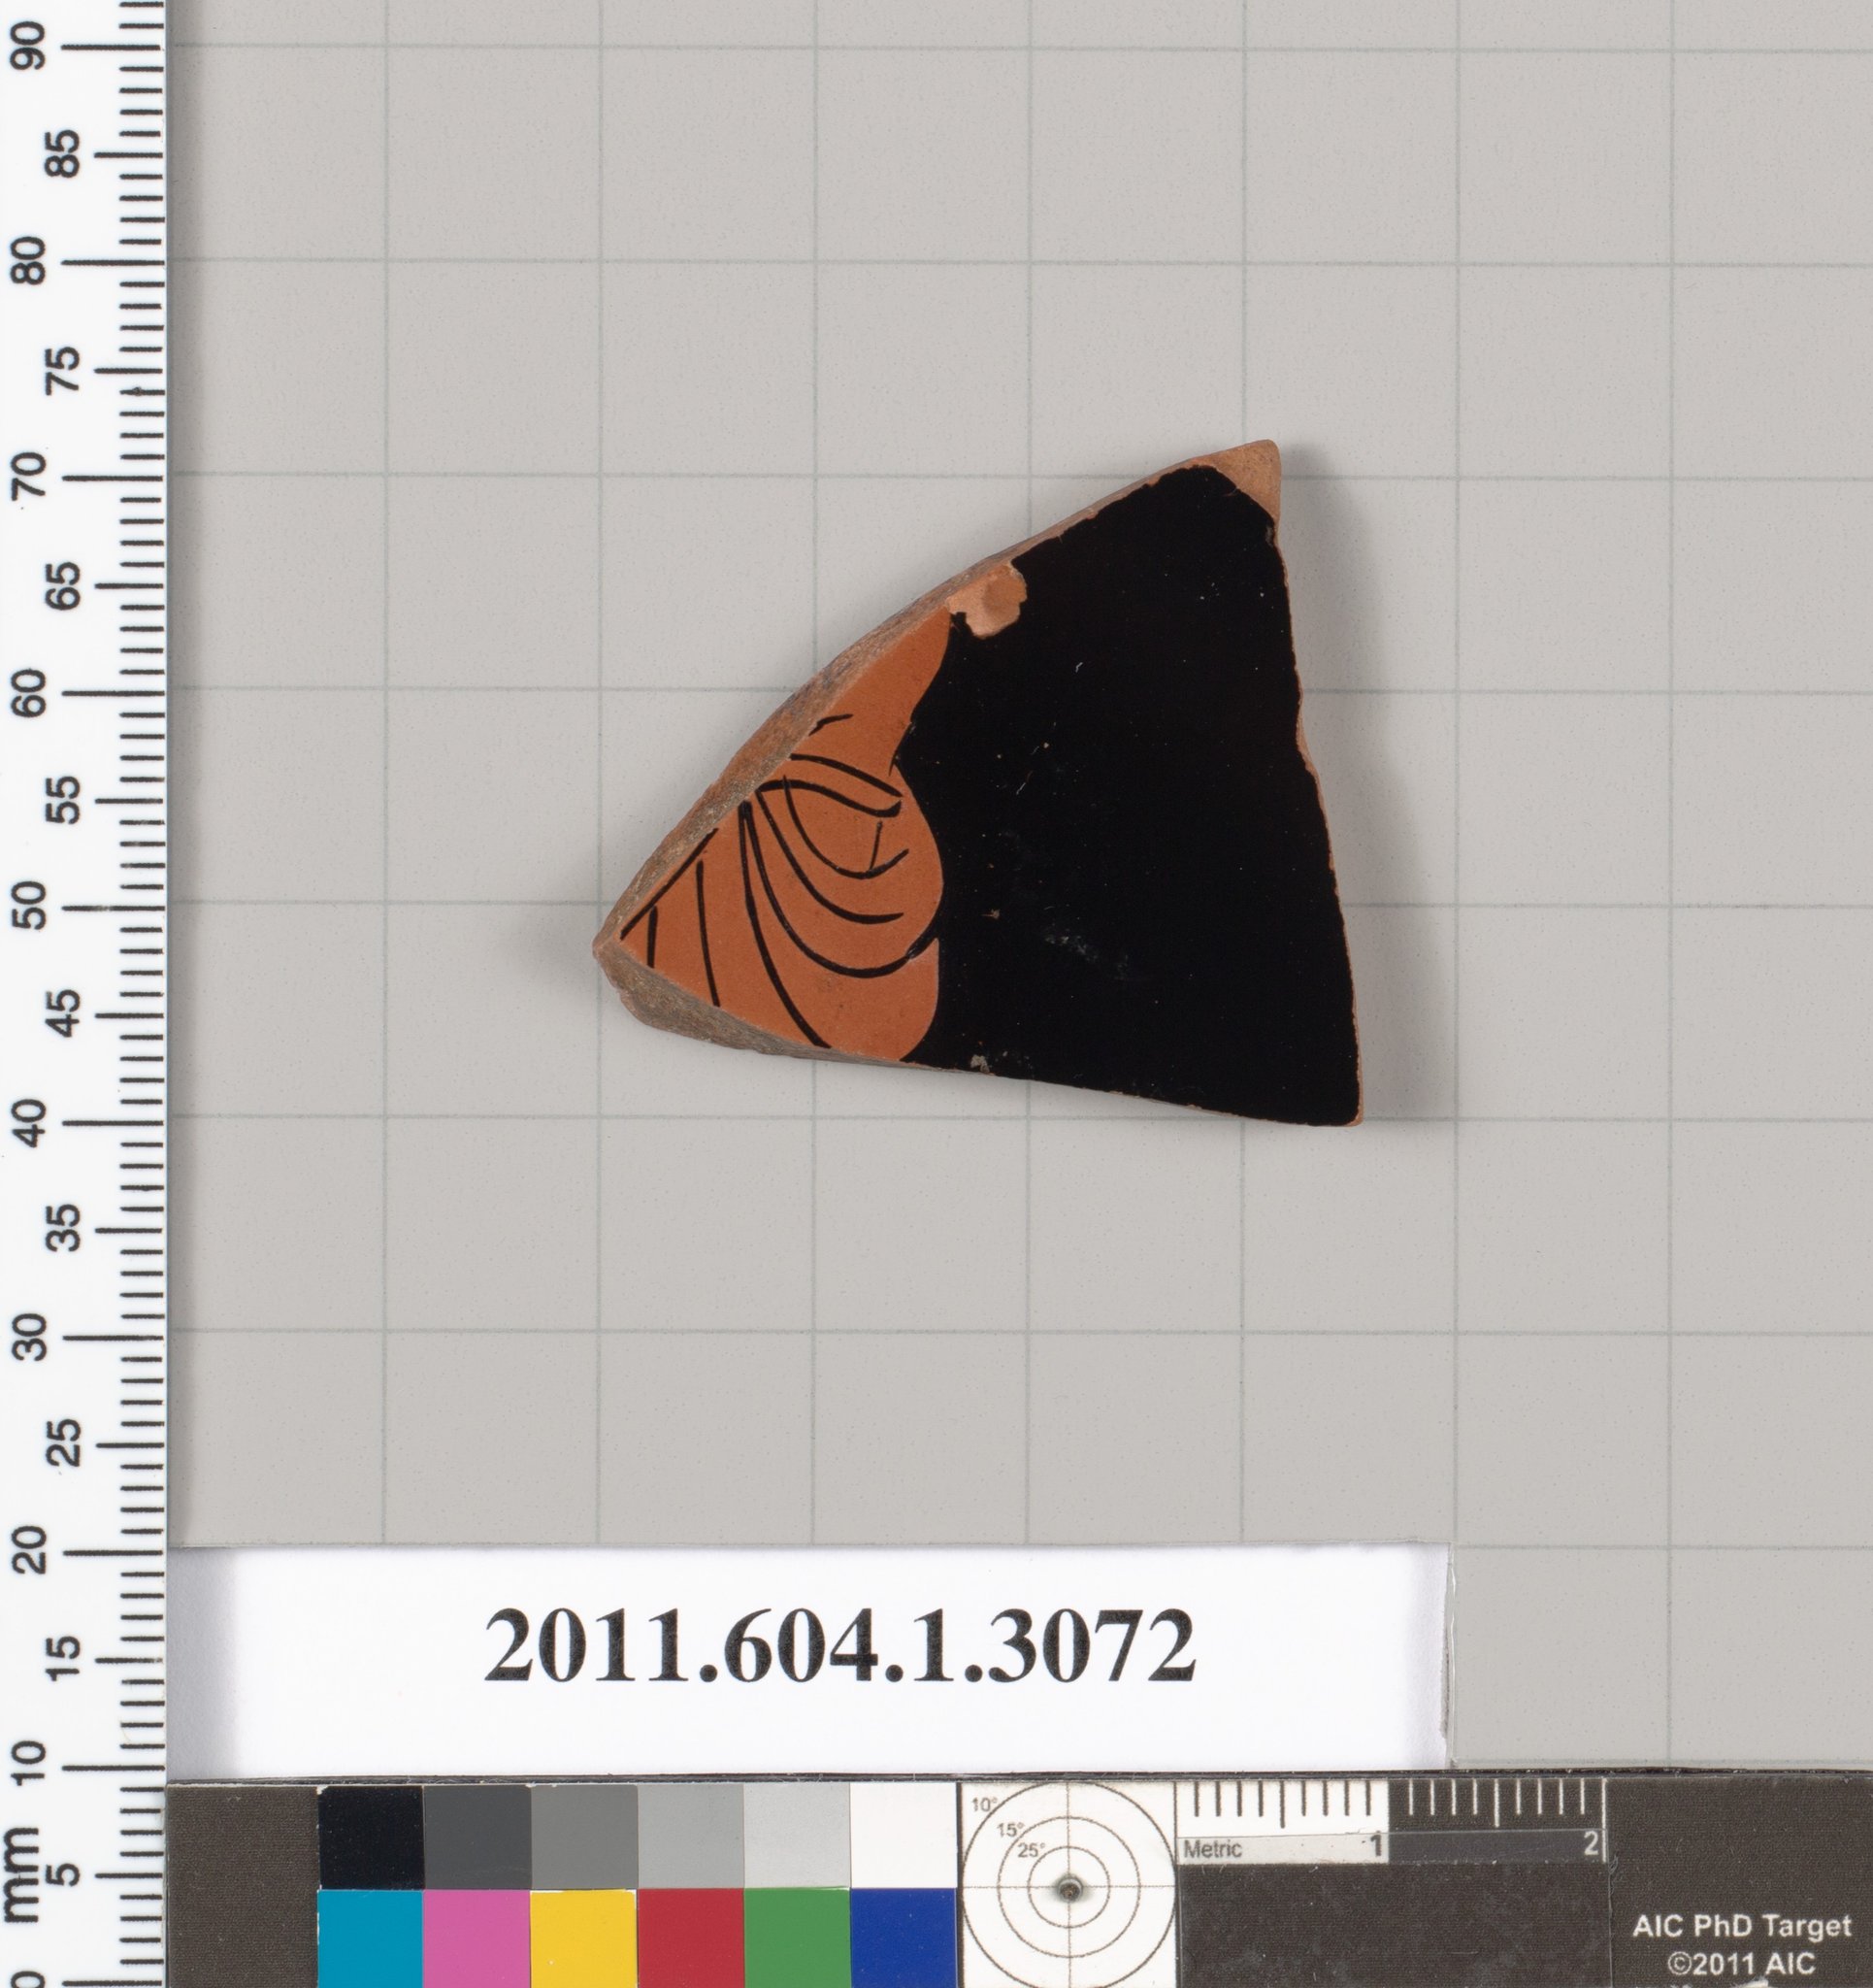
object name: kylix fragment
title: Terracotta fragment of a kylix (drinking cup)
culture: greek, attic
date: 490-480 BCE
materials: terracotta